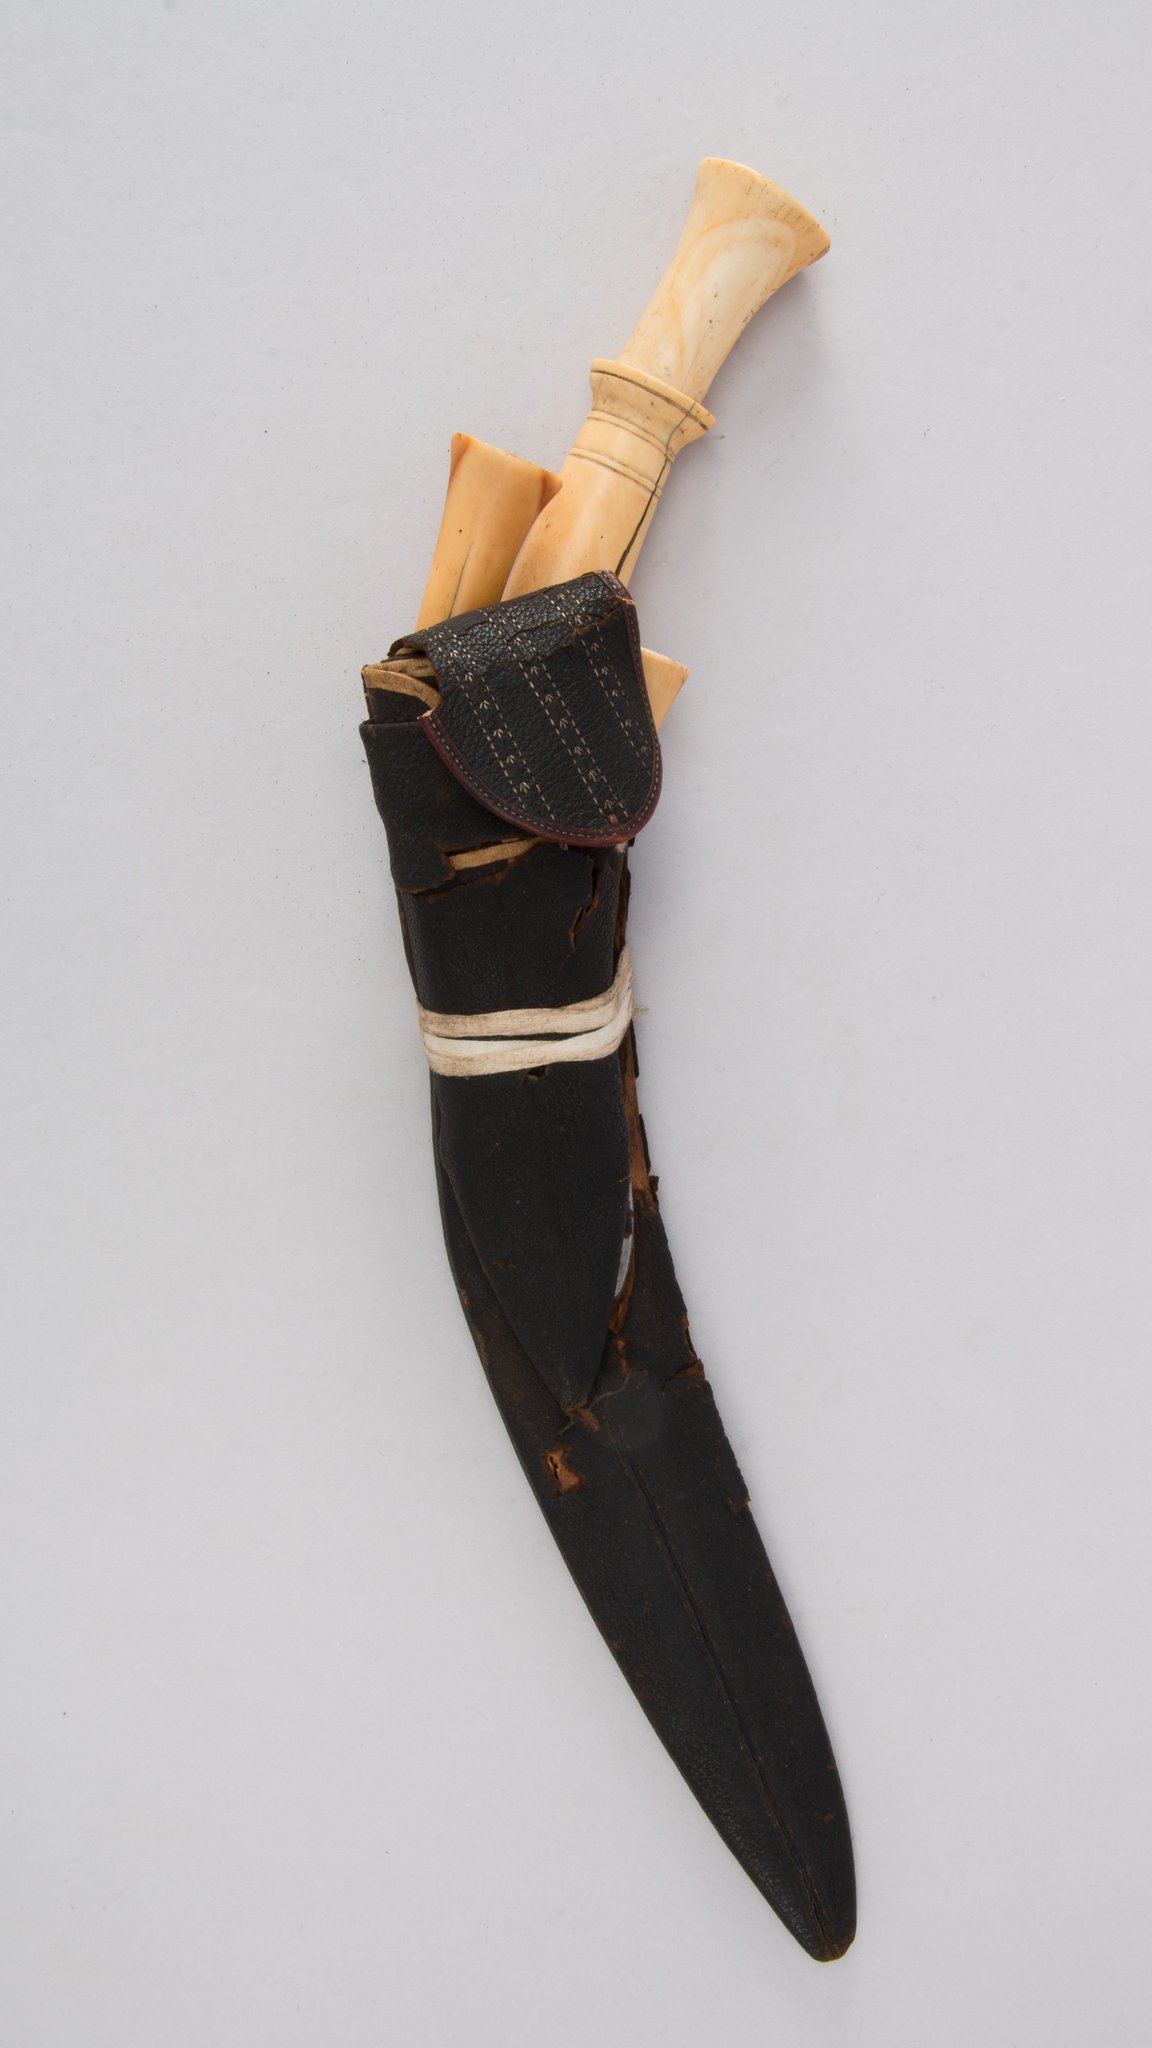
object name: knife kukri with sheath, two small knife and pouch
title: Knife (Kukri) with Sheath, Two Small Knives and Pouch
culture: gurkha or indian or nepalese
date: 1801-1900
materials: ivory, leather, steel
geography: india